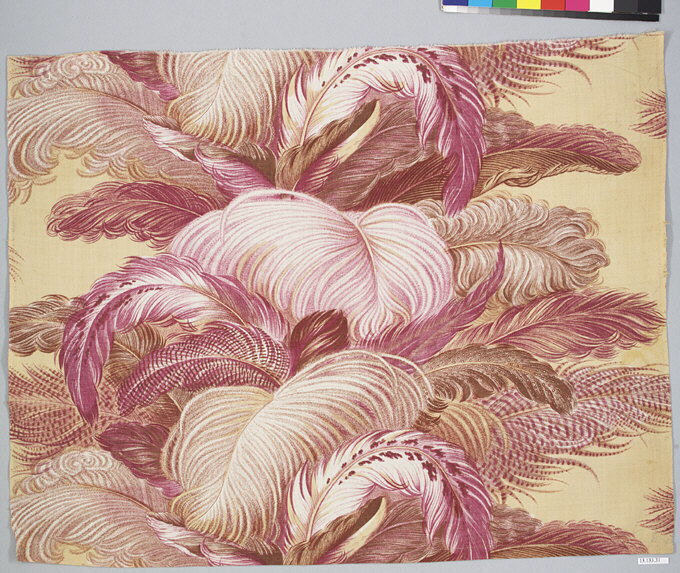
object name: fragment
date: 1801-1900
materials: cotton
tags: feathers